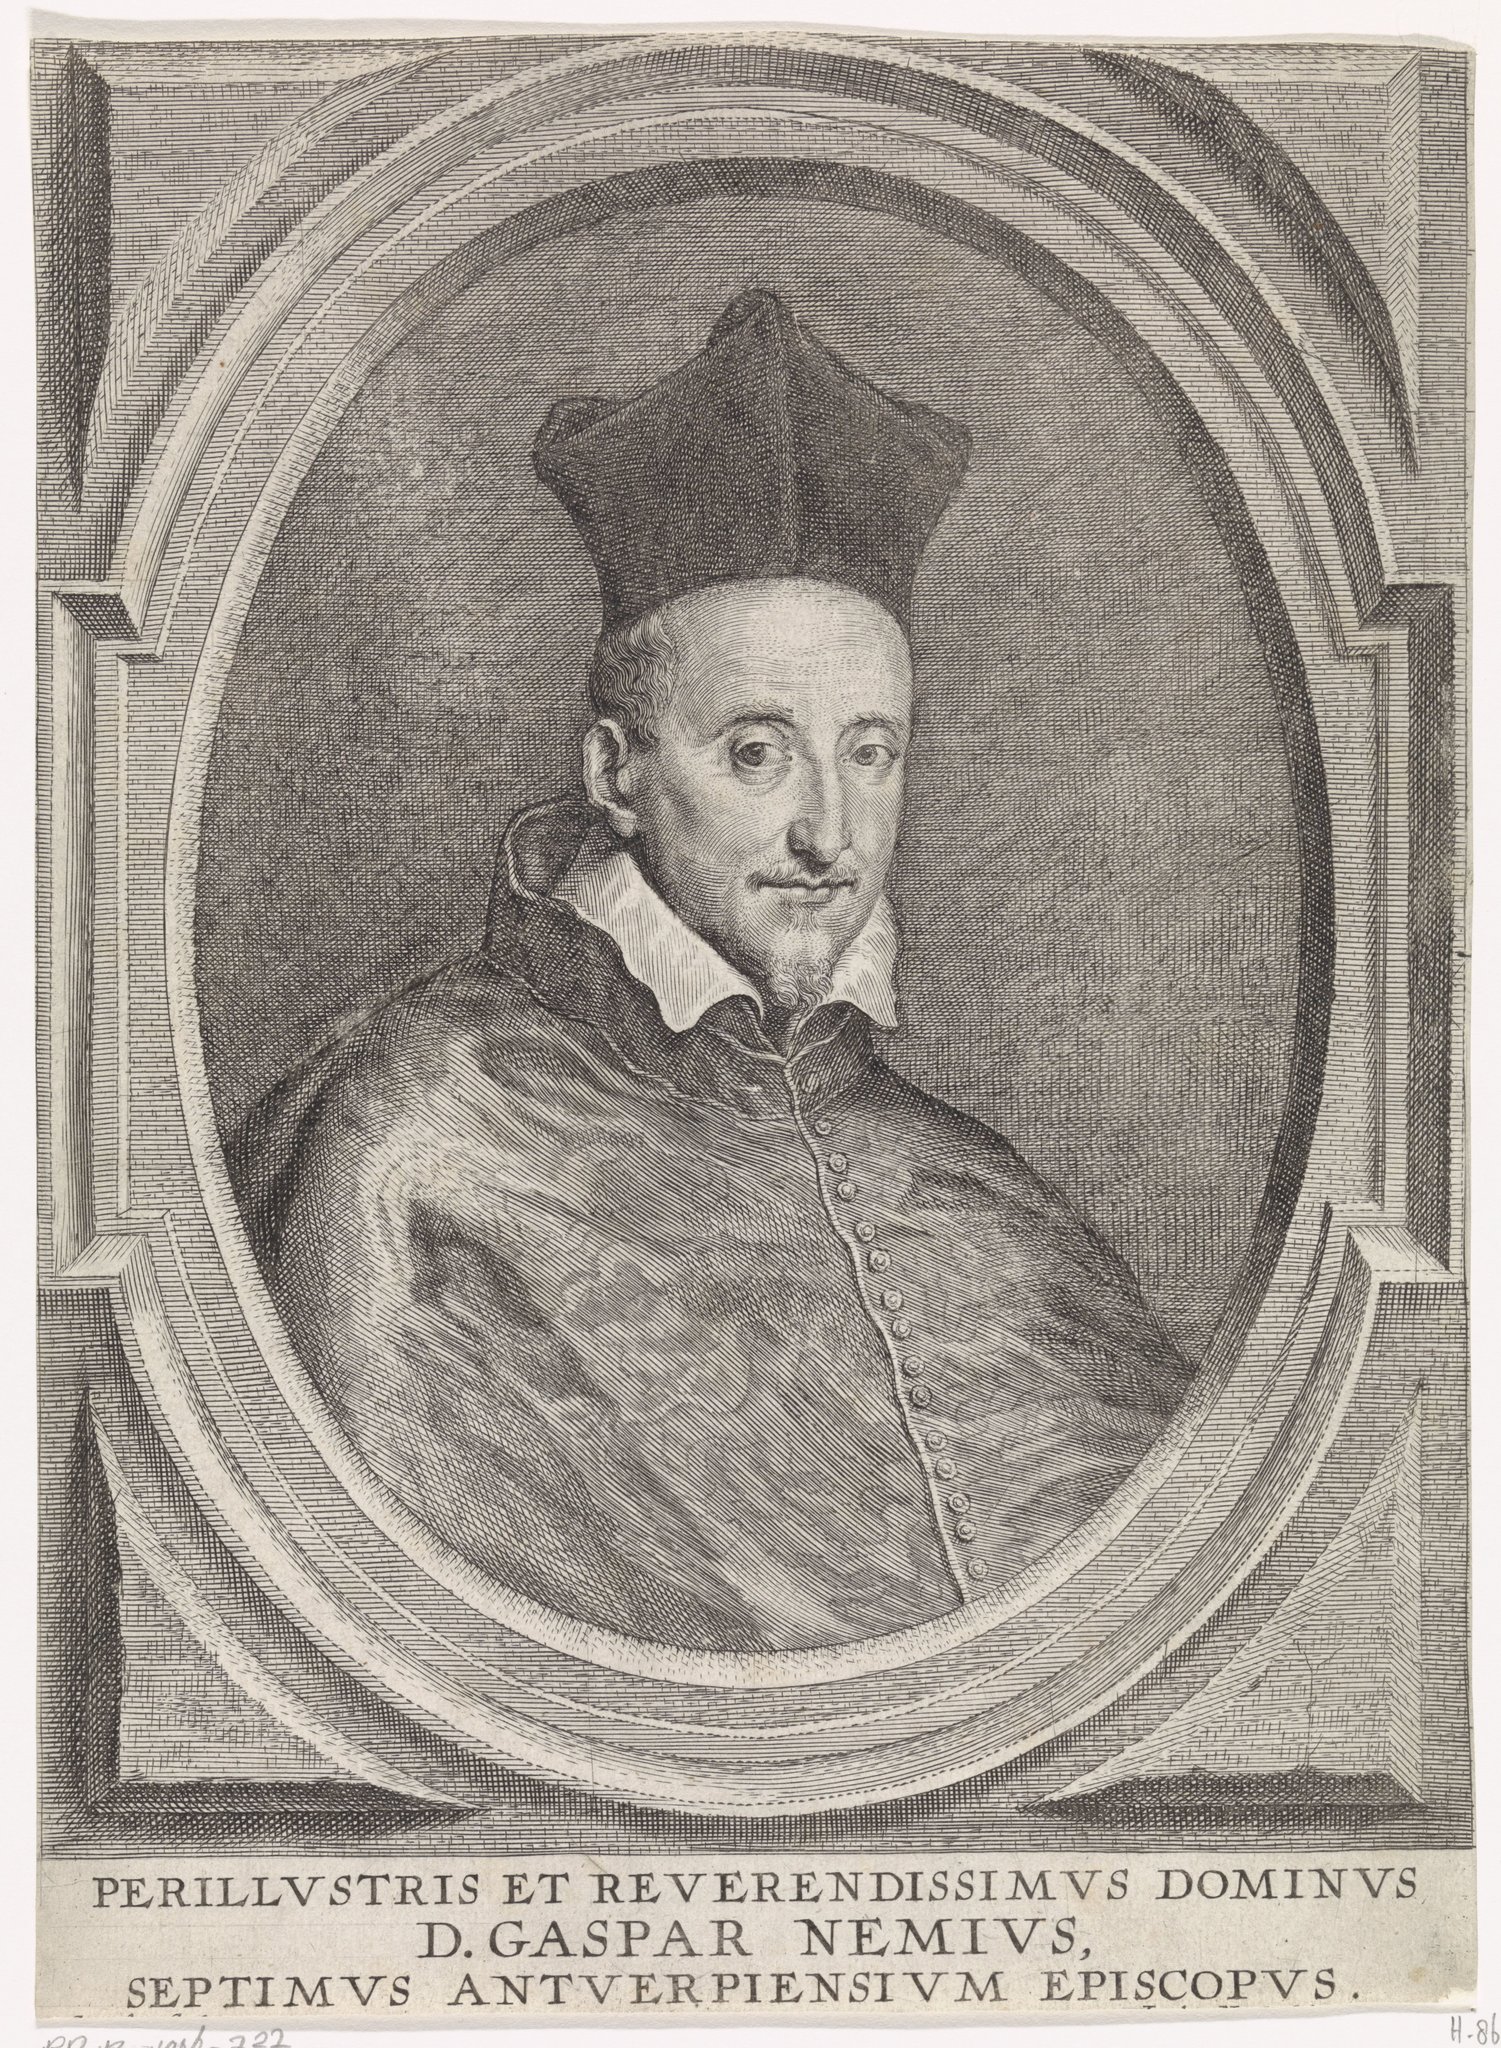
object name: print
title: Portret van bisschop Gaspar Nemius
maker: jacob neefs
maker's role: print maker, publisher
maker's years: 1610-1660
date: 1620-1680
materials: paper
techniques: engraving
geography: antwerp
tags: gaspar nemius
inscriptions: collector's mark: Lugt 2228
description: Gaspar Nemius, bisschop van Antwerpen, draagt een biretta op het hoofd en is gekleed in een mozetta. Buste naar rechts in een ovaal. Onderaan in de marge een drieregelige tekst in het Latijn.